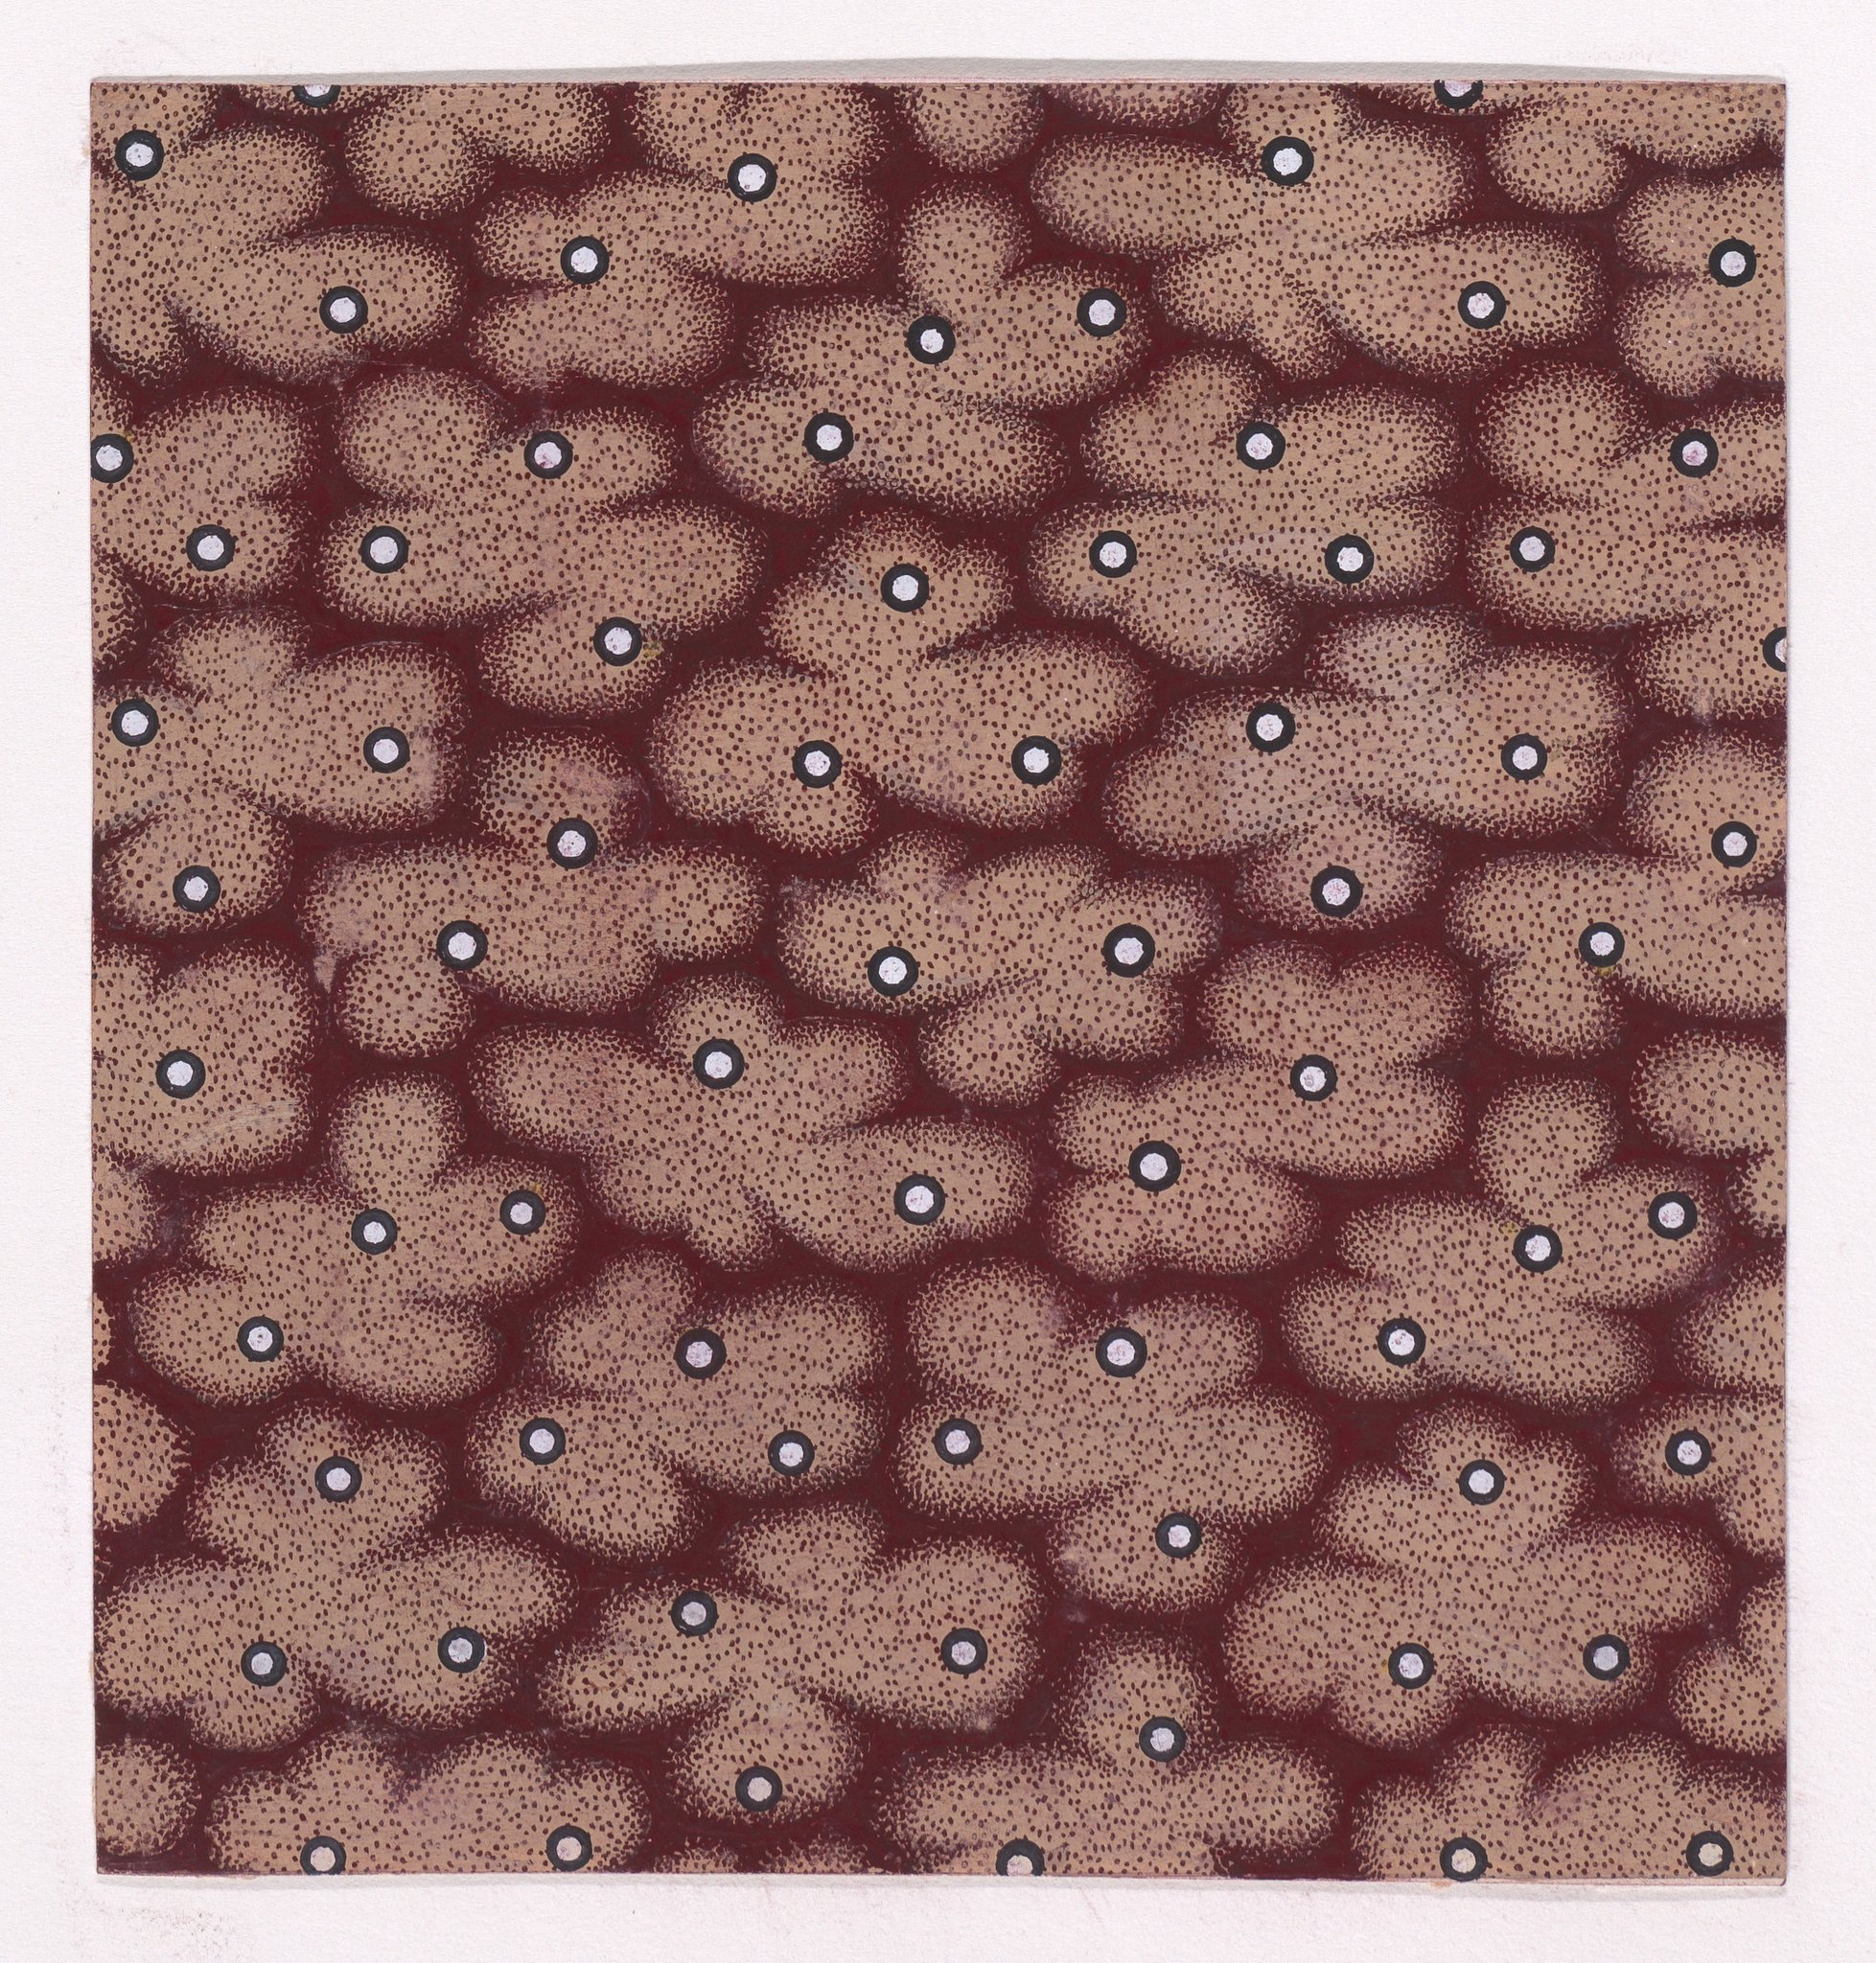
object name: drawing ornament architecture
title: Textile Design with Cloud-Like Figures and Pearls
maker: anonymous, alsatian, 19th century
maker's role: artist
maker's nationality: alsatian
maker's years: 1800-1900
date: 1840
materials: gouache